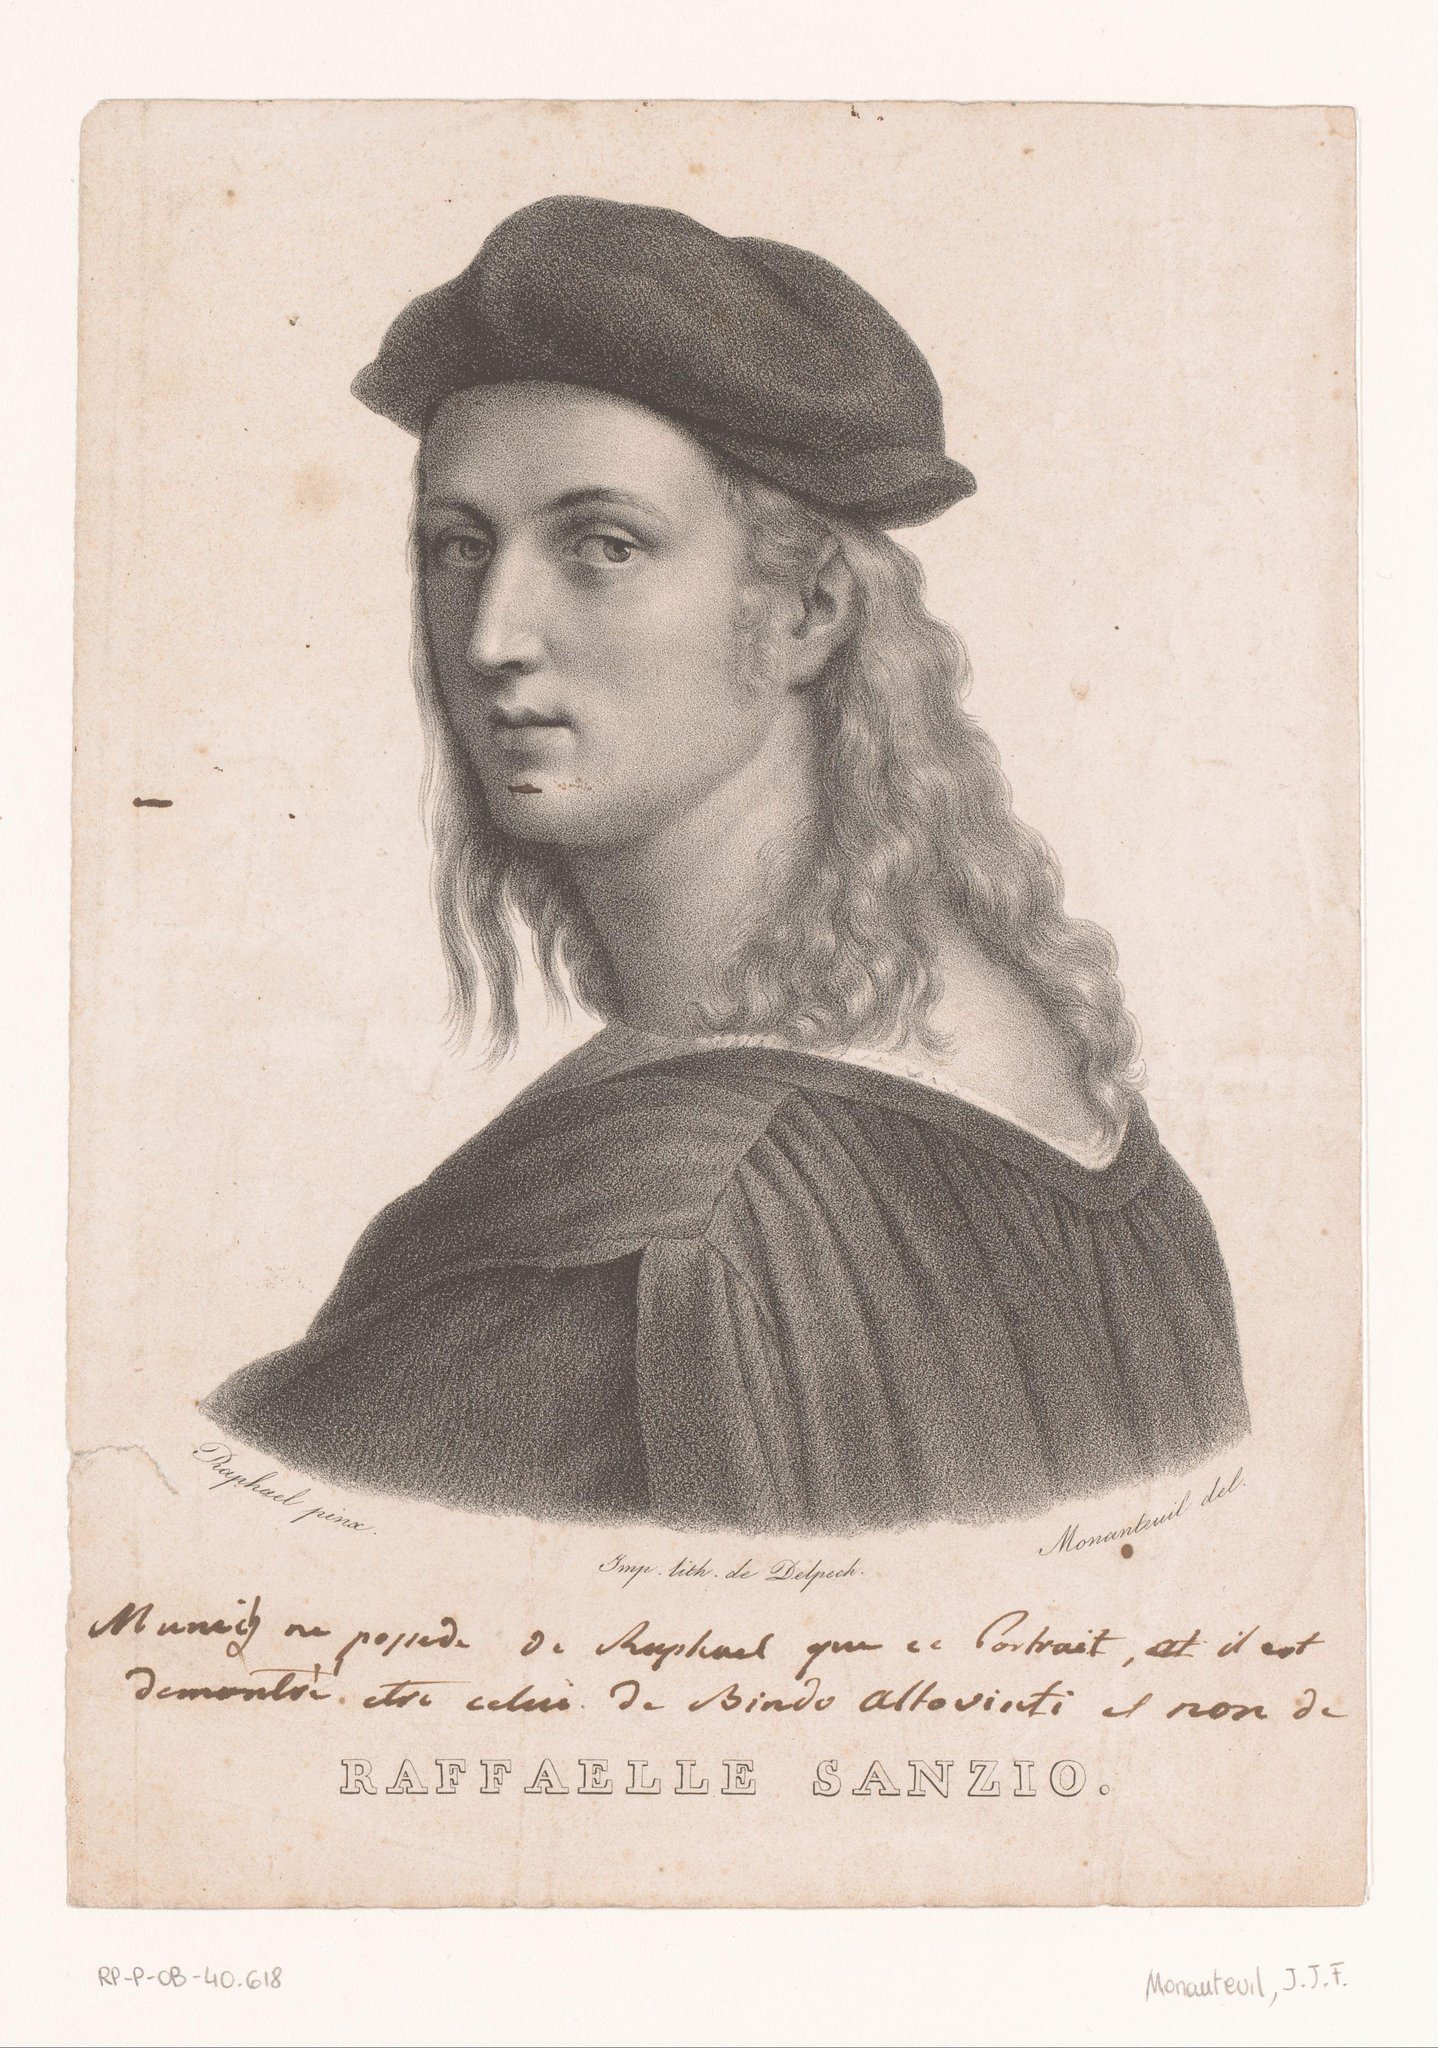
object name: print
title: Raffaelle Sanzio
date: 1818-1842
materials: paper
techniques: lithograph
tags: rome, painter, rafaël, historical persons, portrait, self-portrait of painter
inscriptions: inscription: ‘Munich ne possede de Raphael (...)’